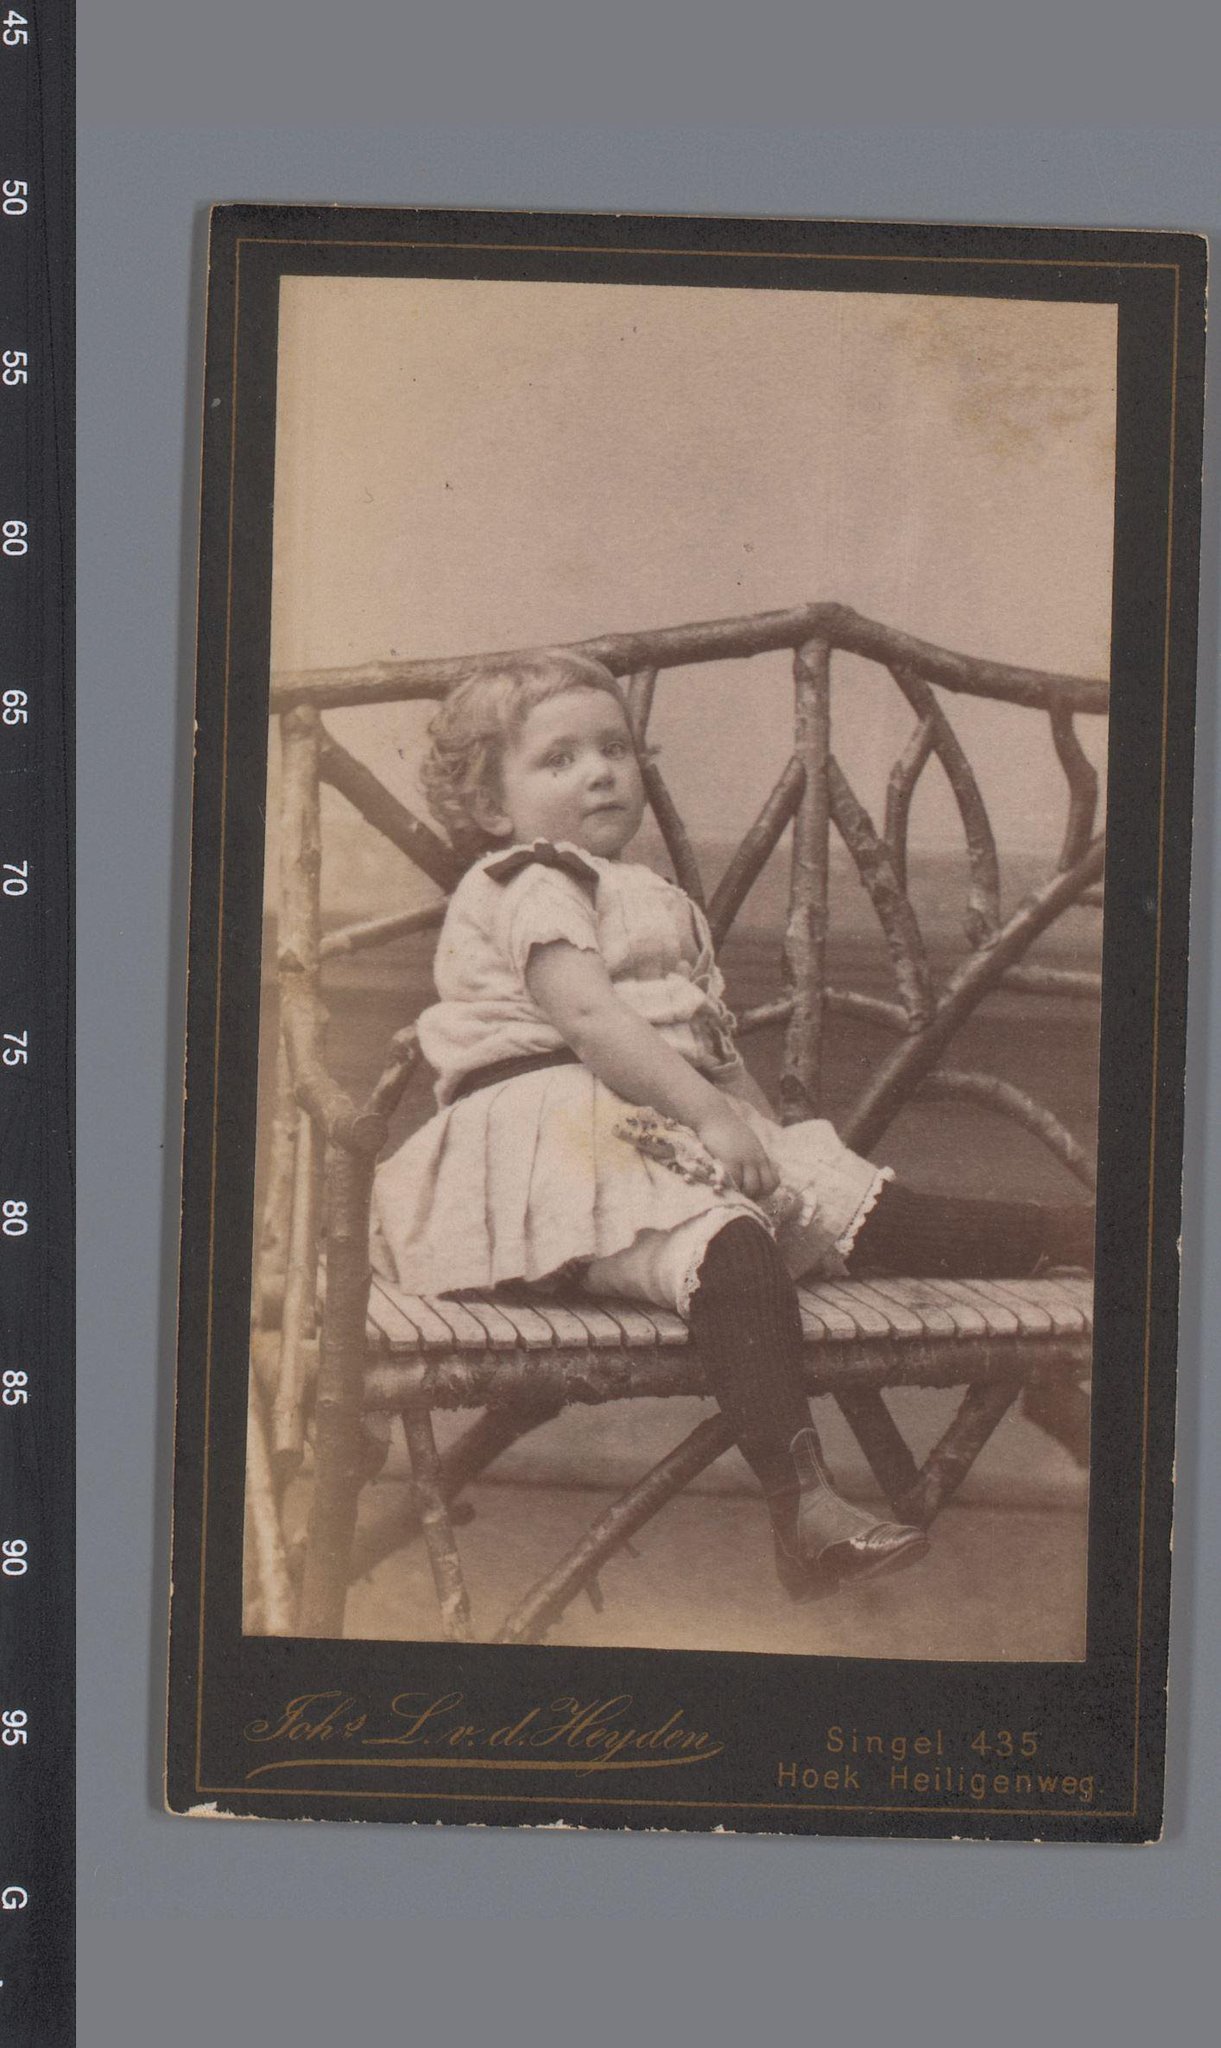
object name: photograph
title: Portret van een onbekend meisje, zittend op een bank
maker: johannes leonardus van der heijden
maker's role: fotograaf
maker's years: 1856-1937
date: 1875-1900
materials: cardboard, paper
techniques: albumen print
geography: amsterdam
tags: bench, historical persons, girl (child between toddler and youth)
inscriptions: inscription: ‘Johs L. v.d. Heijden/ AMSTERDAM Singel 435.’